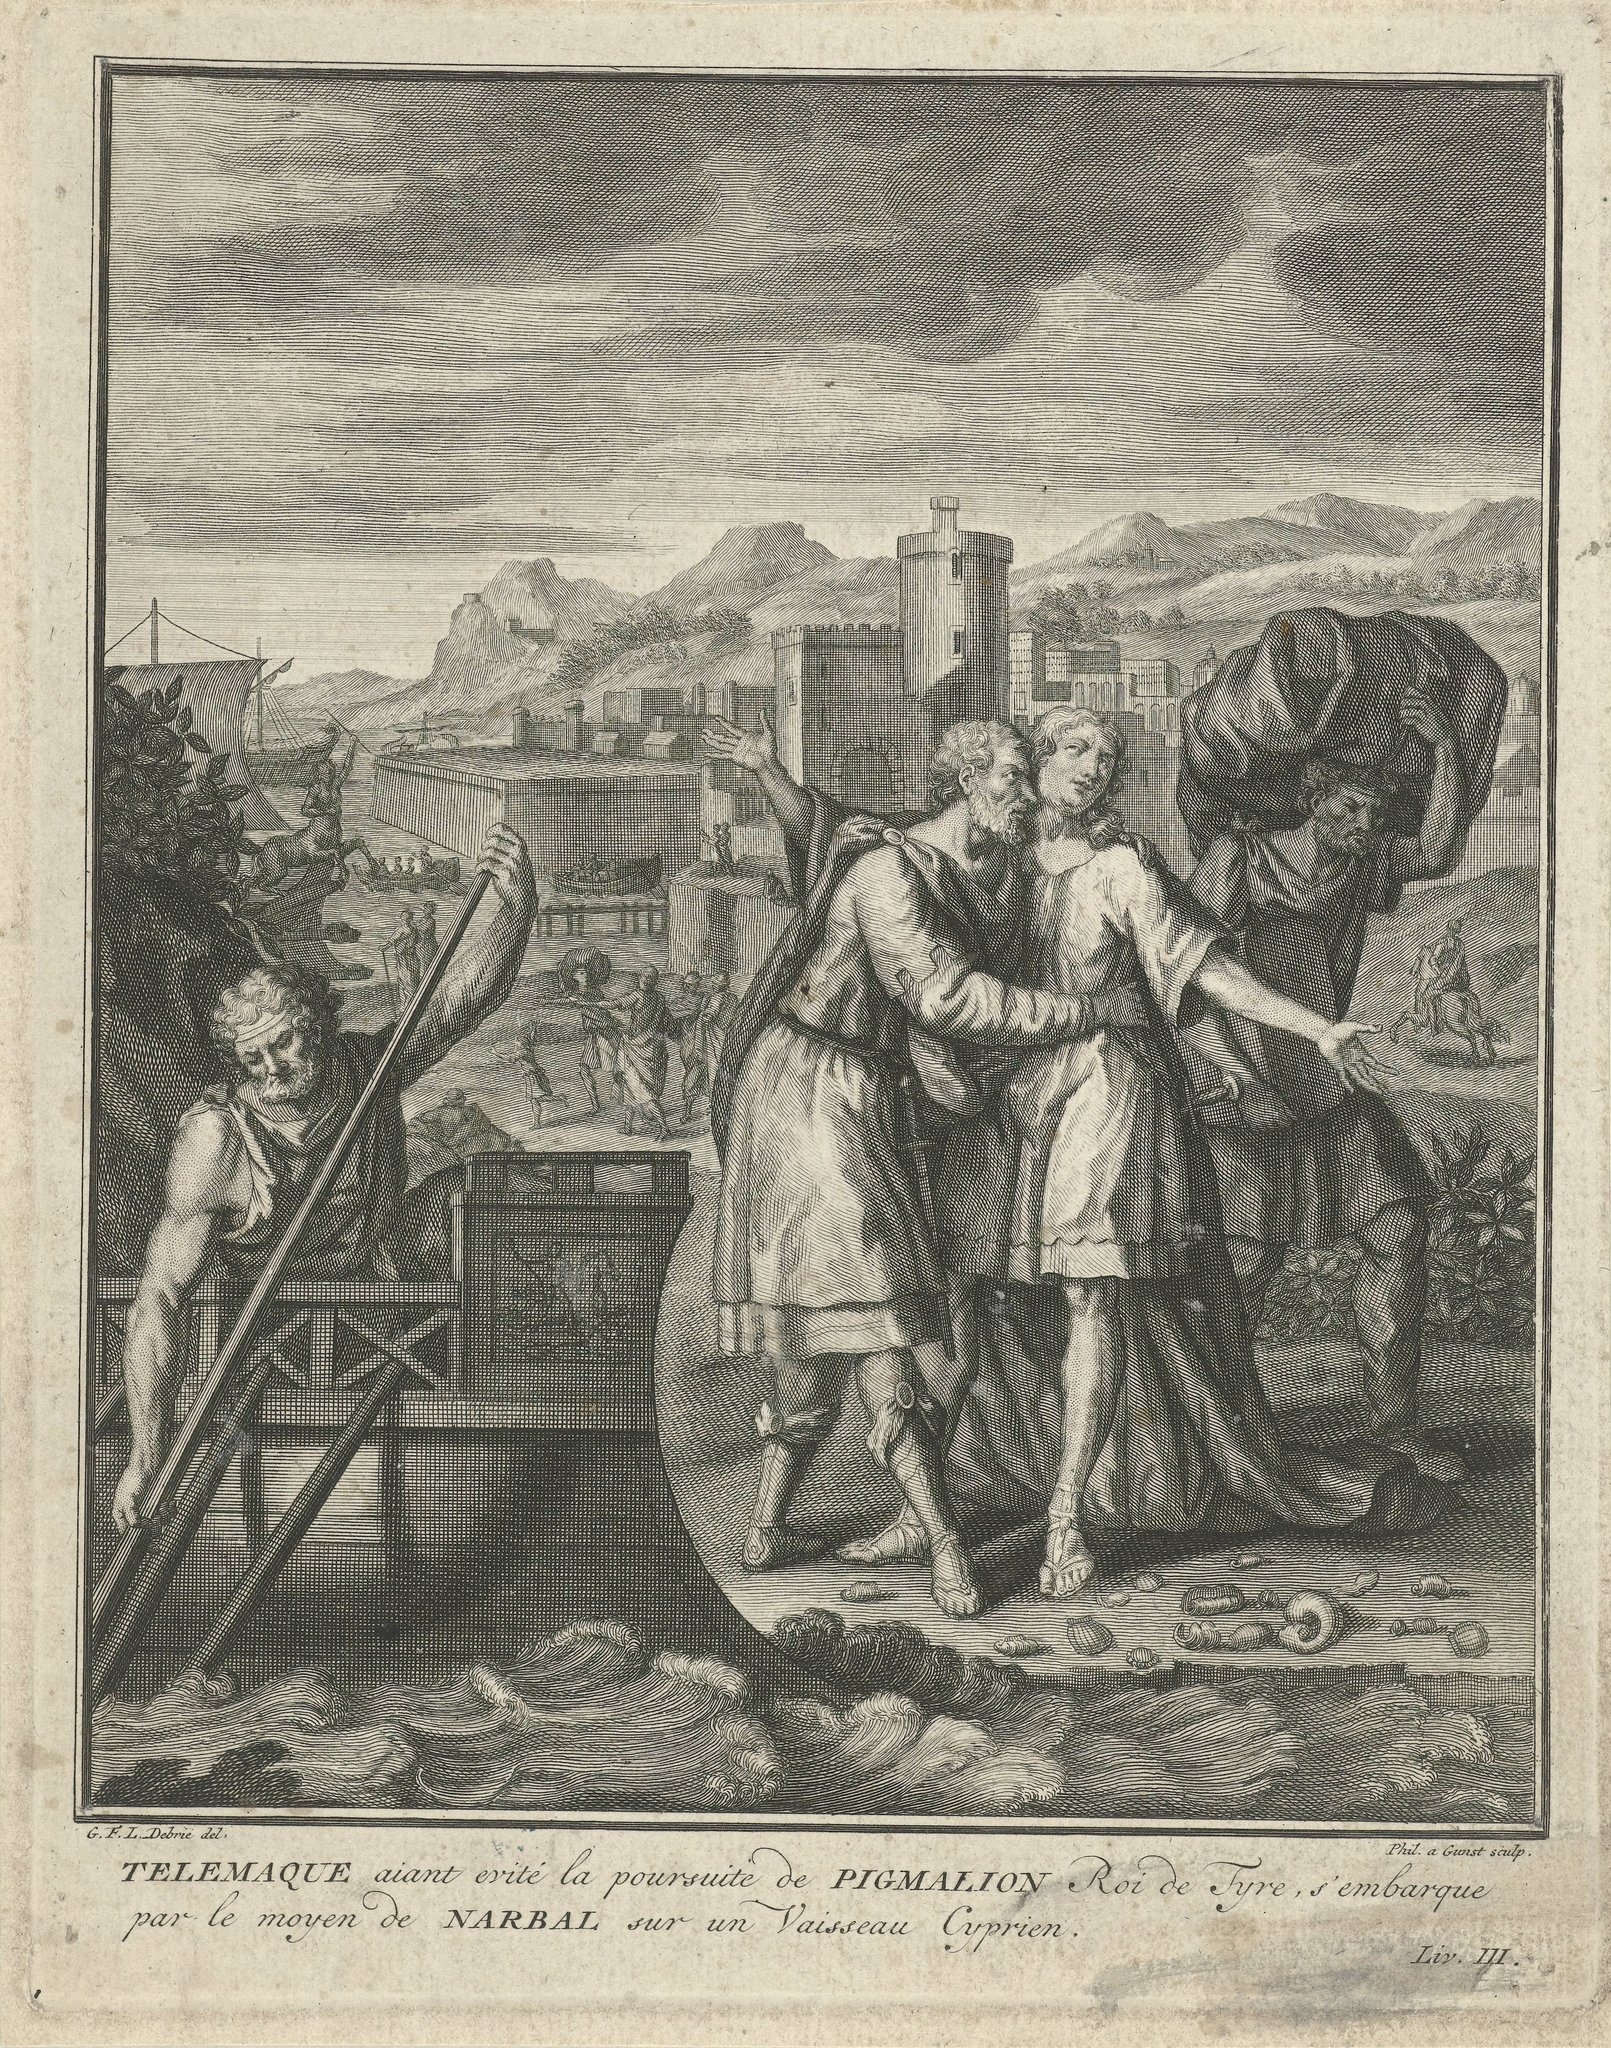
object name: print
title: Narbal neemt afscheid van Telemachus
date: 1734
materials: paper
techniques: engraving, etching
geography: amsterdam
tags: harbour, non-aggressive, friendly or neutral activities and relationships of telemachus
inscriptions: collector's mark: Lugt 2228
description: In de haven van Tyros neemt Narbal afscheid van Telemachus, die per schip naar Cyprus zal reizen. Narbal omarmt de jongeling. De prent heeft een Frans onderschrift.